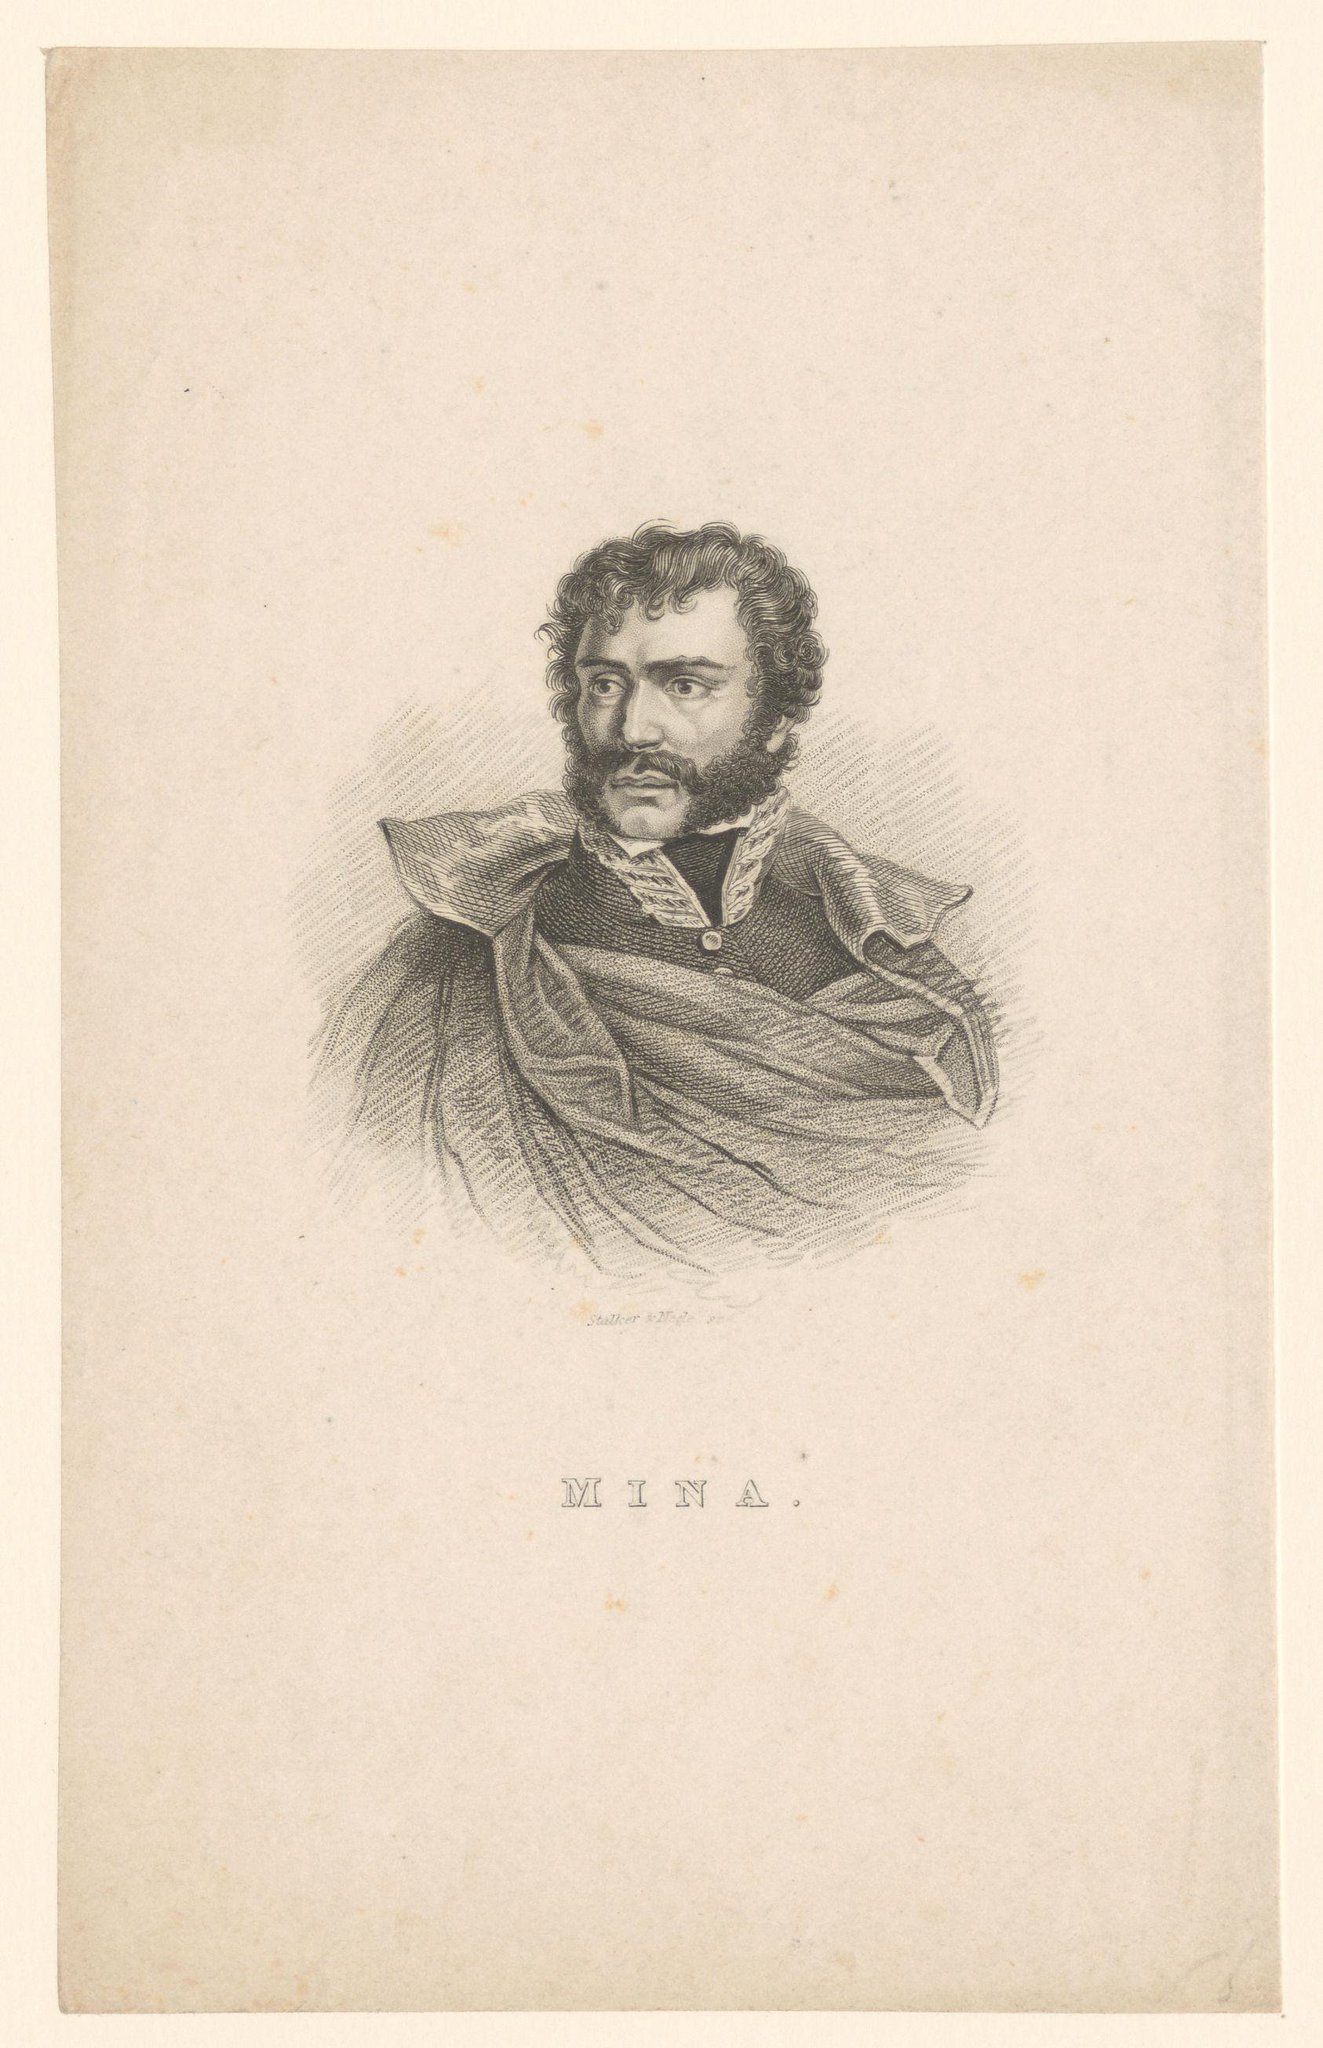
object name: print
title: Mina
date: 1820-1850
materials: paper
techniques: etching, roulette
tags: historical persons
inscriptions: collector's mark: Lugt 2228